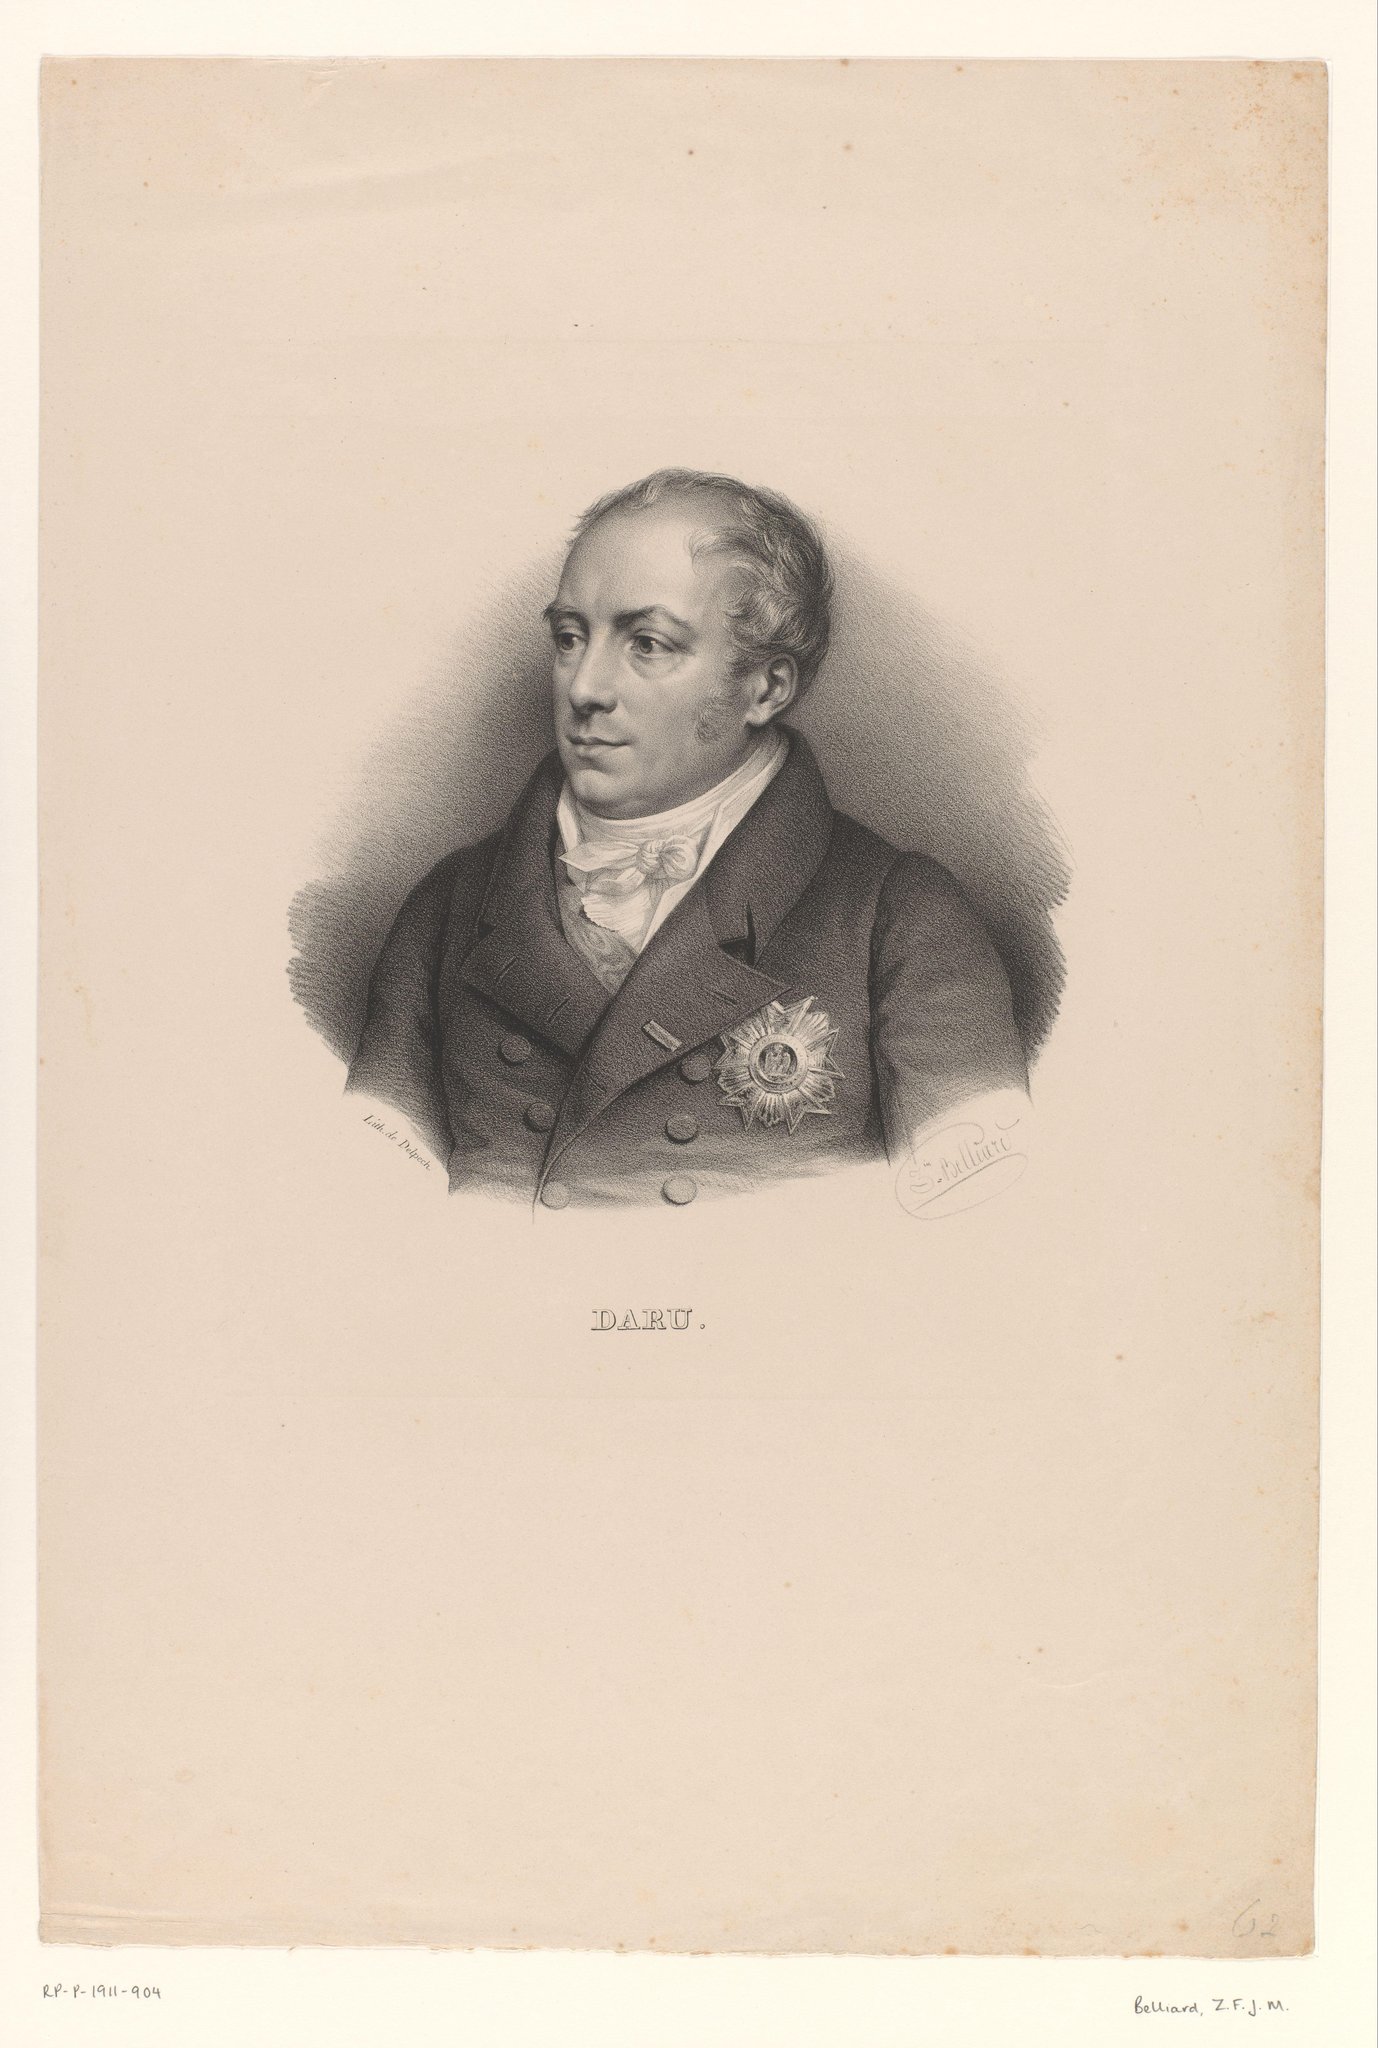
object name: print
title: Portret van de staatsman en dichter Pierre Daru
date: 1833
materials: paper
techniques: lithograph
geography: paris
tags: historical persons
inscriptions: collector's mark: Lugt 2228a